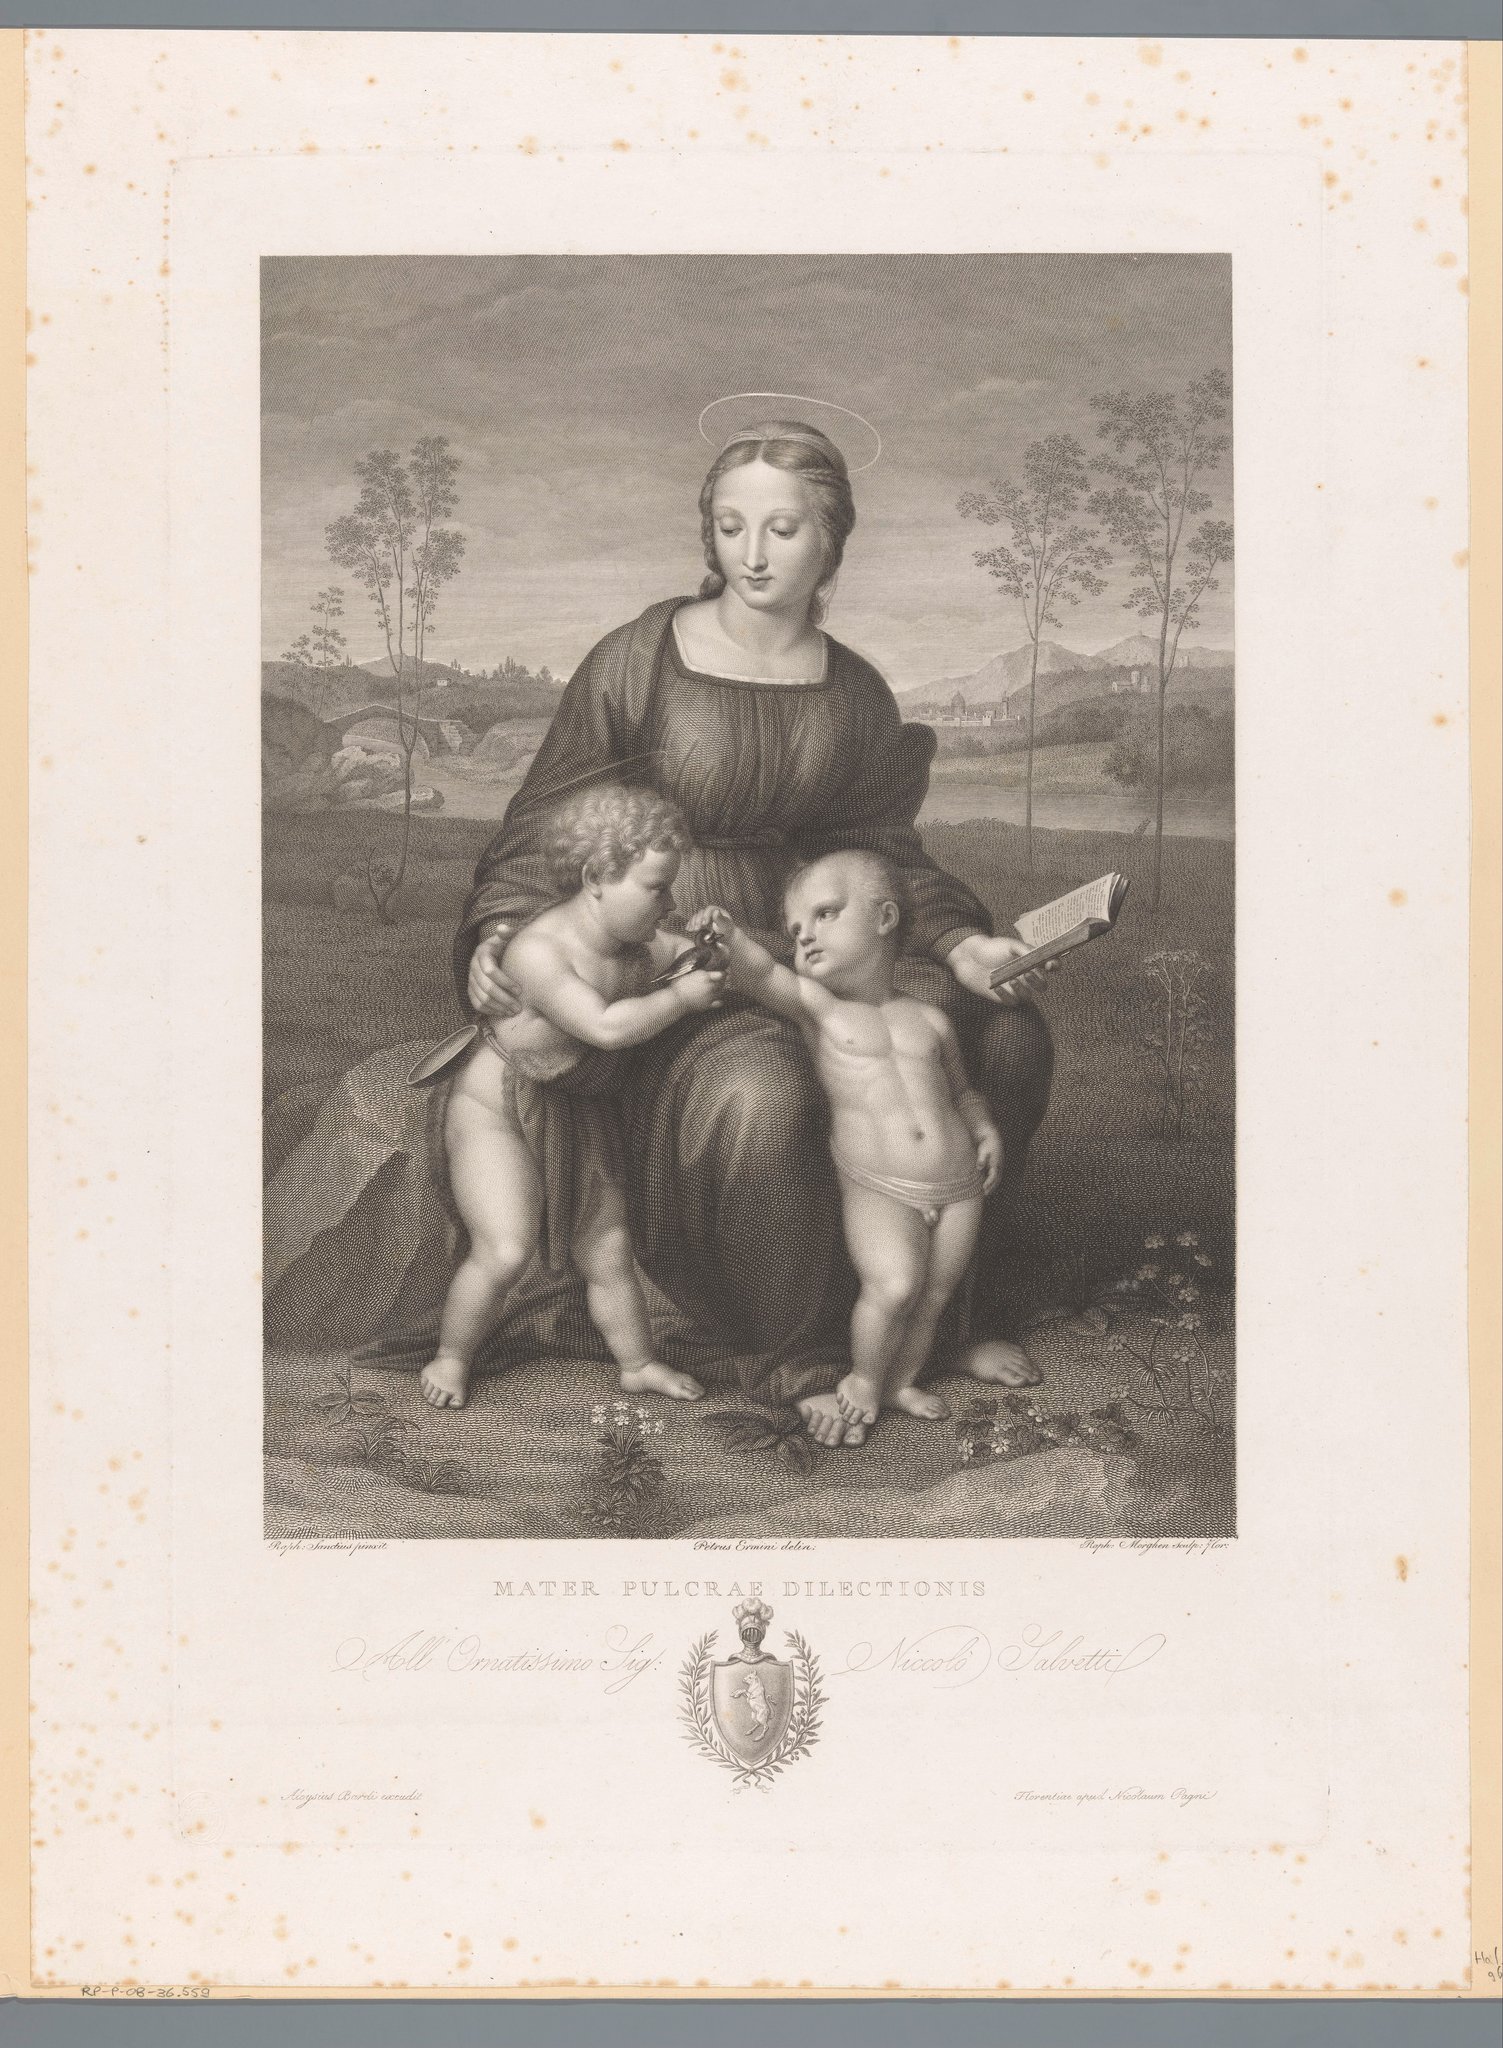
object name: print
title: Madonna del Cardellino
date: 1768-1833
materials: paper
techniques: engraving, etching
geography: italy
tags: mary and the christ-child with john the baptist (as child), song-birds: goldfinch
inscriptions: collector's mark, collector's mark: Lugt 12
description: Naar het schilderij 'Madonna del Cardellino' door Rafaël in de Galleria degli Uffizi te Florence.